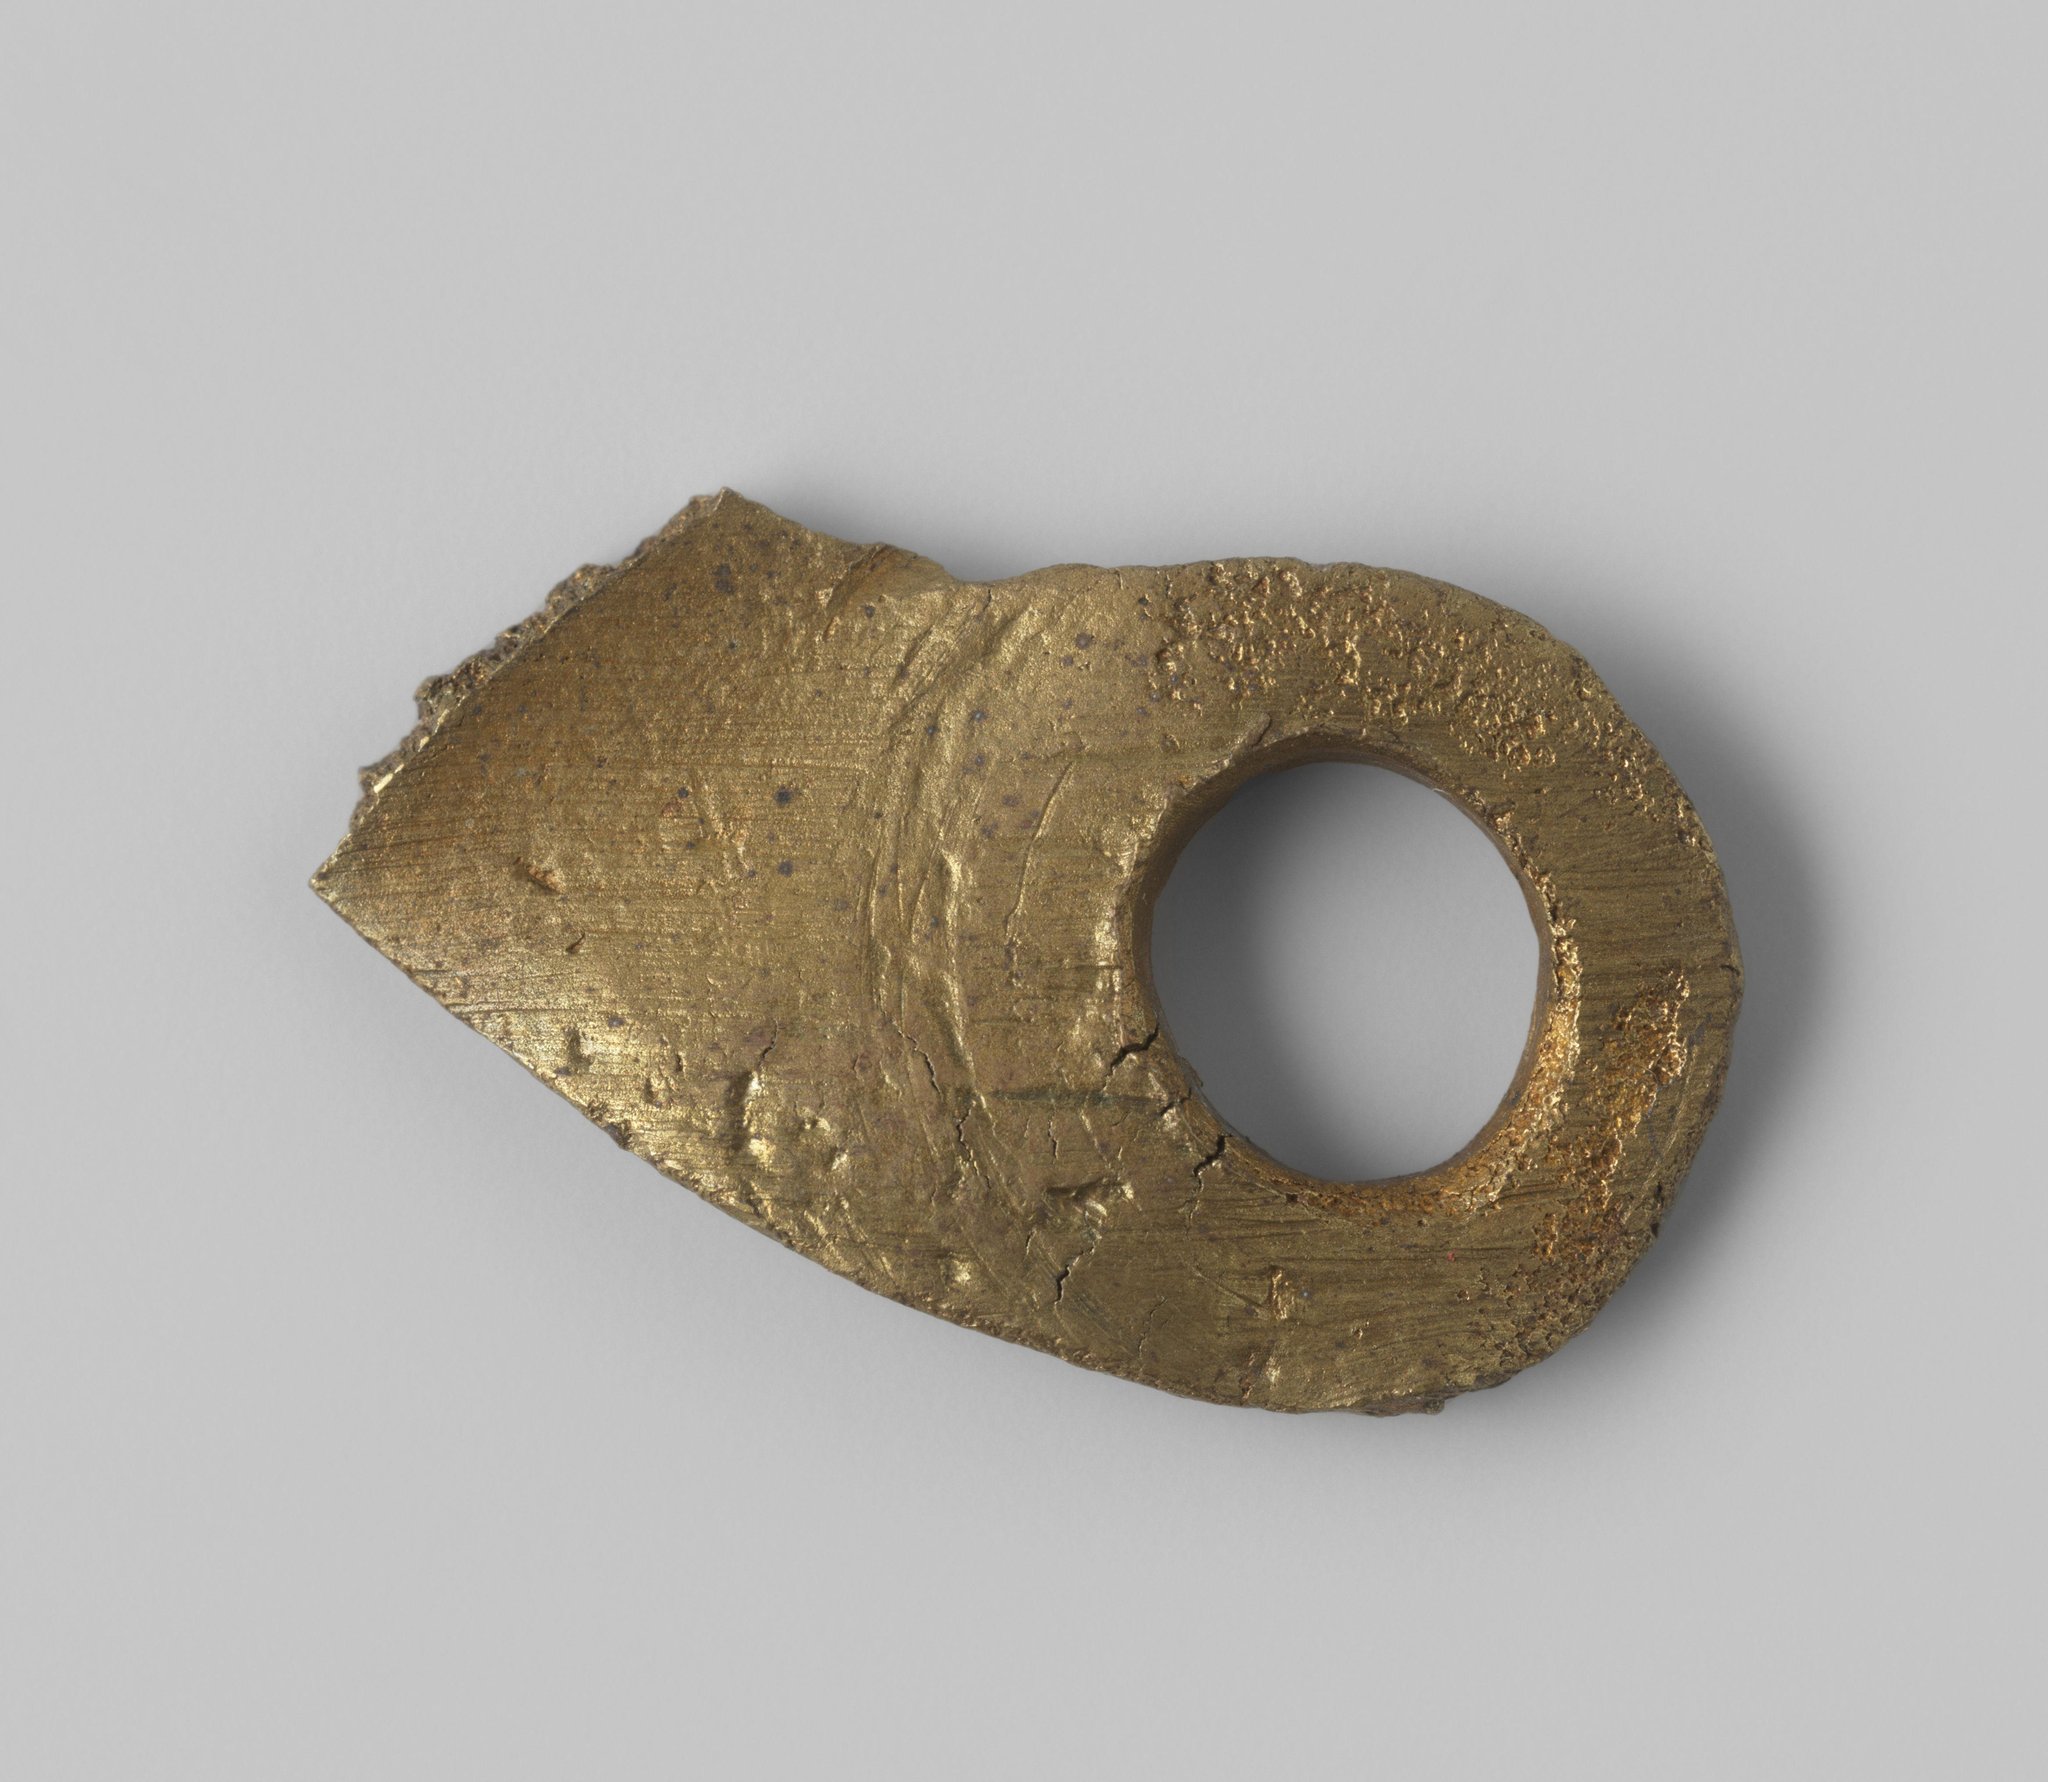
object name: schroefplaat, schroefblik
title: Fragment schroefplaat van een musket uit het wrak van de Oost-Indiëvaarder Hollandia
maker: Anonymous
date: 1700-1743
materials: copper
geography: netherlands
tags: verenigde oostindische compagnie, hollandia (schip), annet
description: Fragm, eye, id. NG 1978-74H986 or NG 1980-27H3069, side plate.